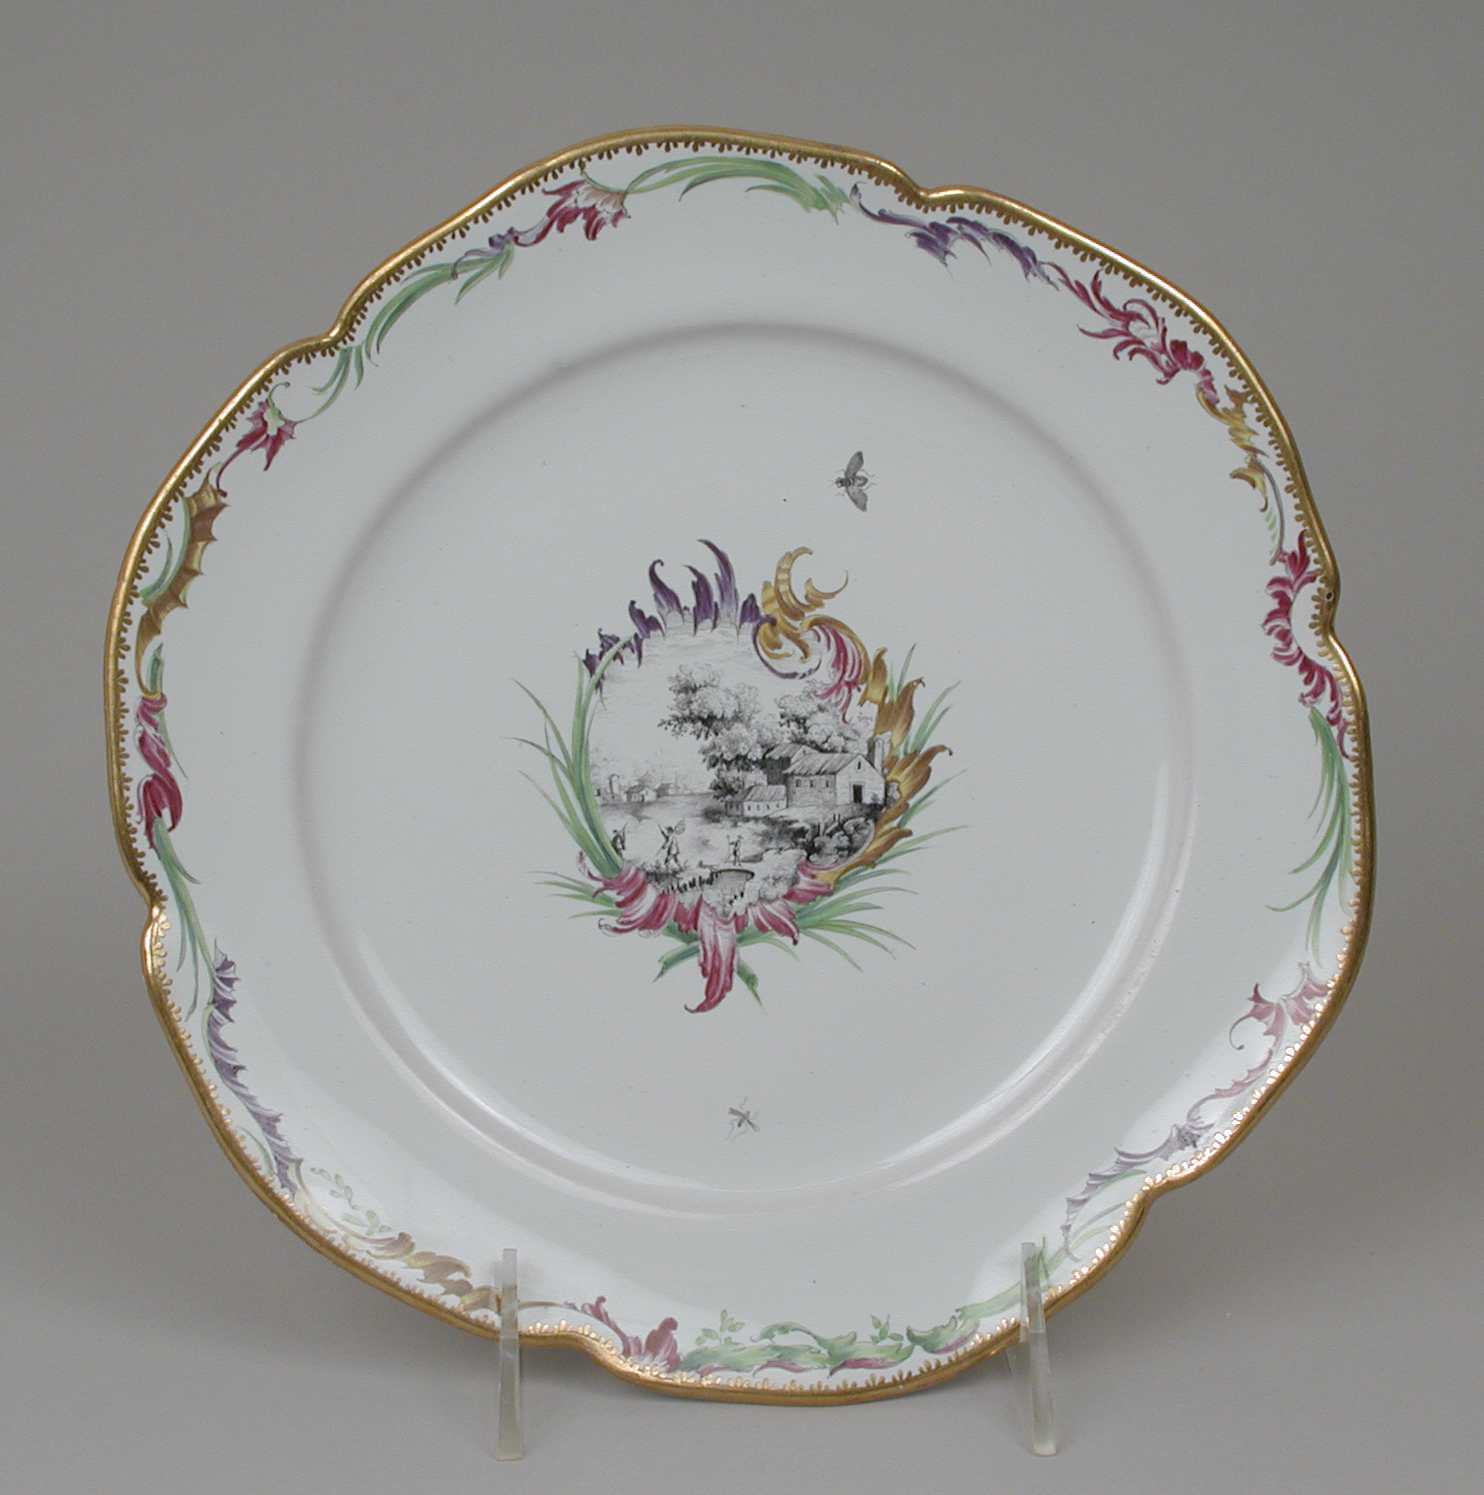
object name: plate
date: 1748-1754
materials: faience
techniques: glazing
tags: landscapes